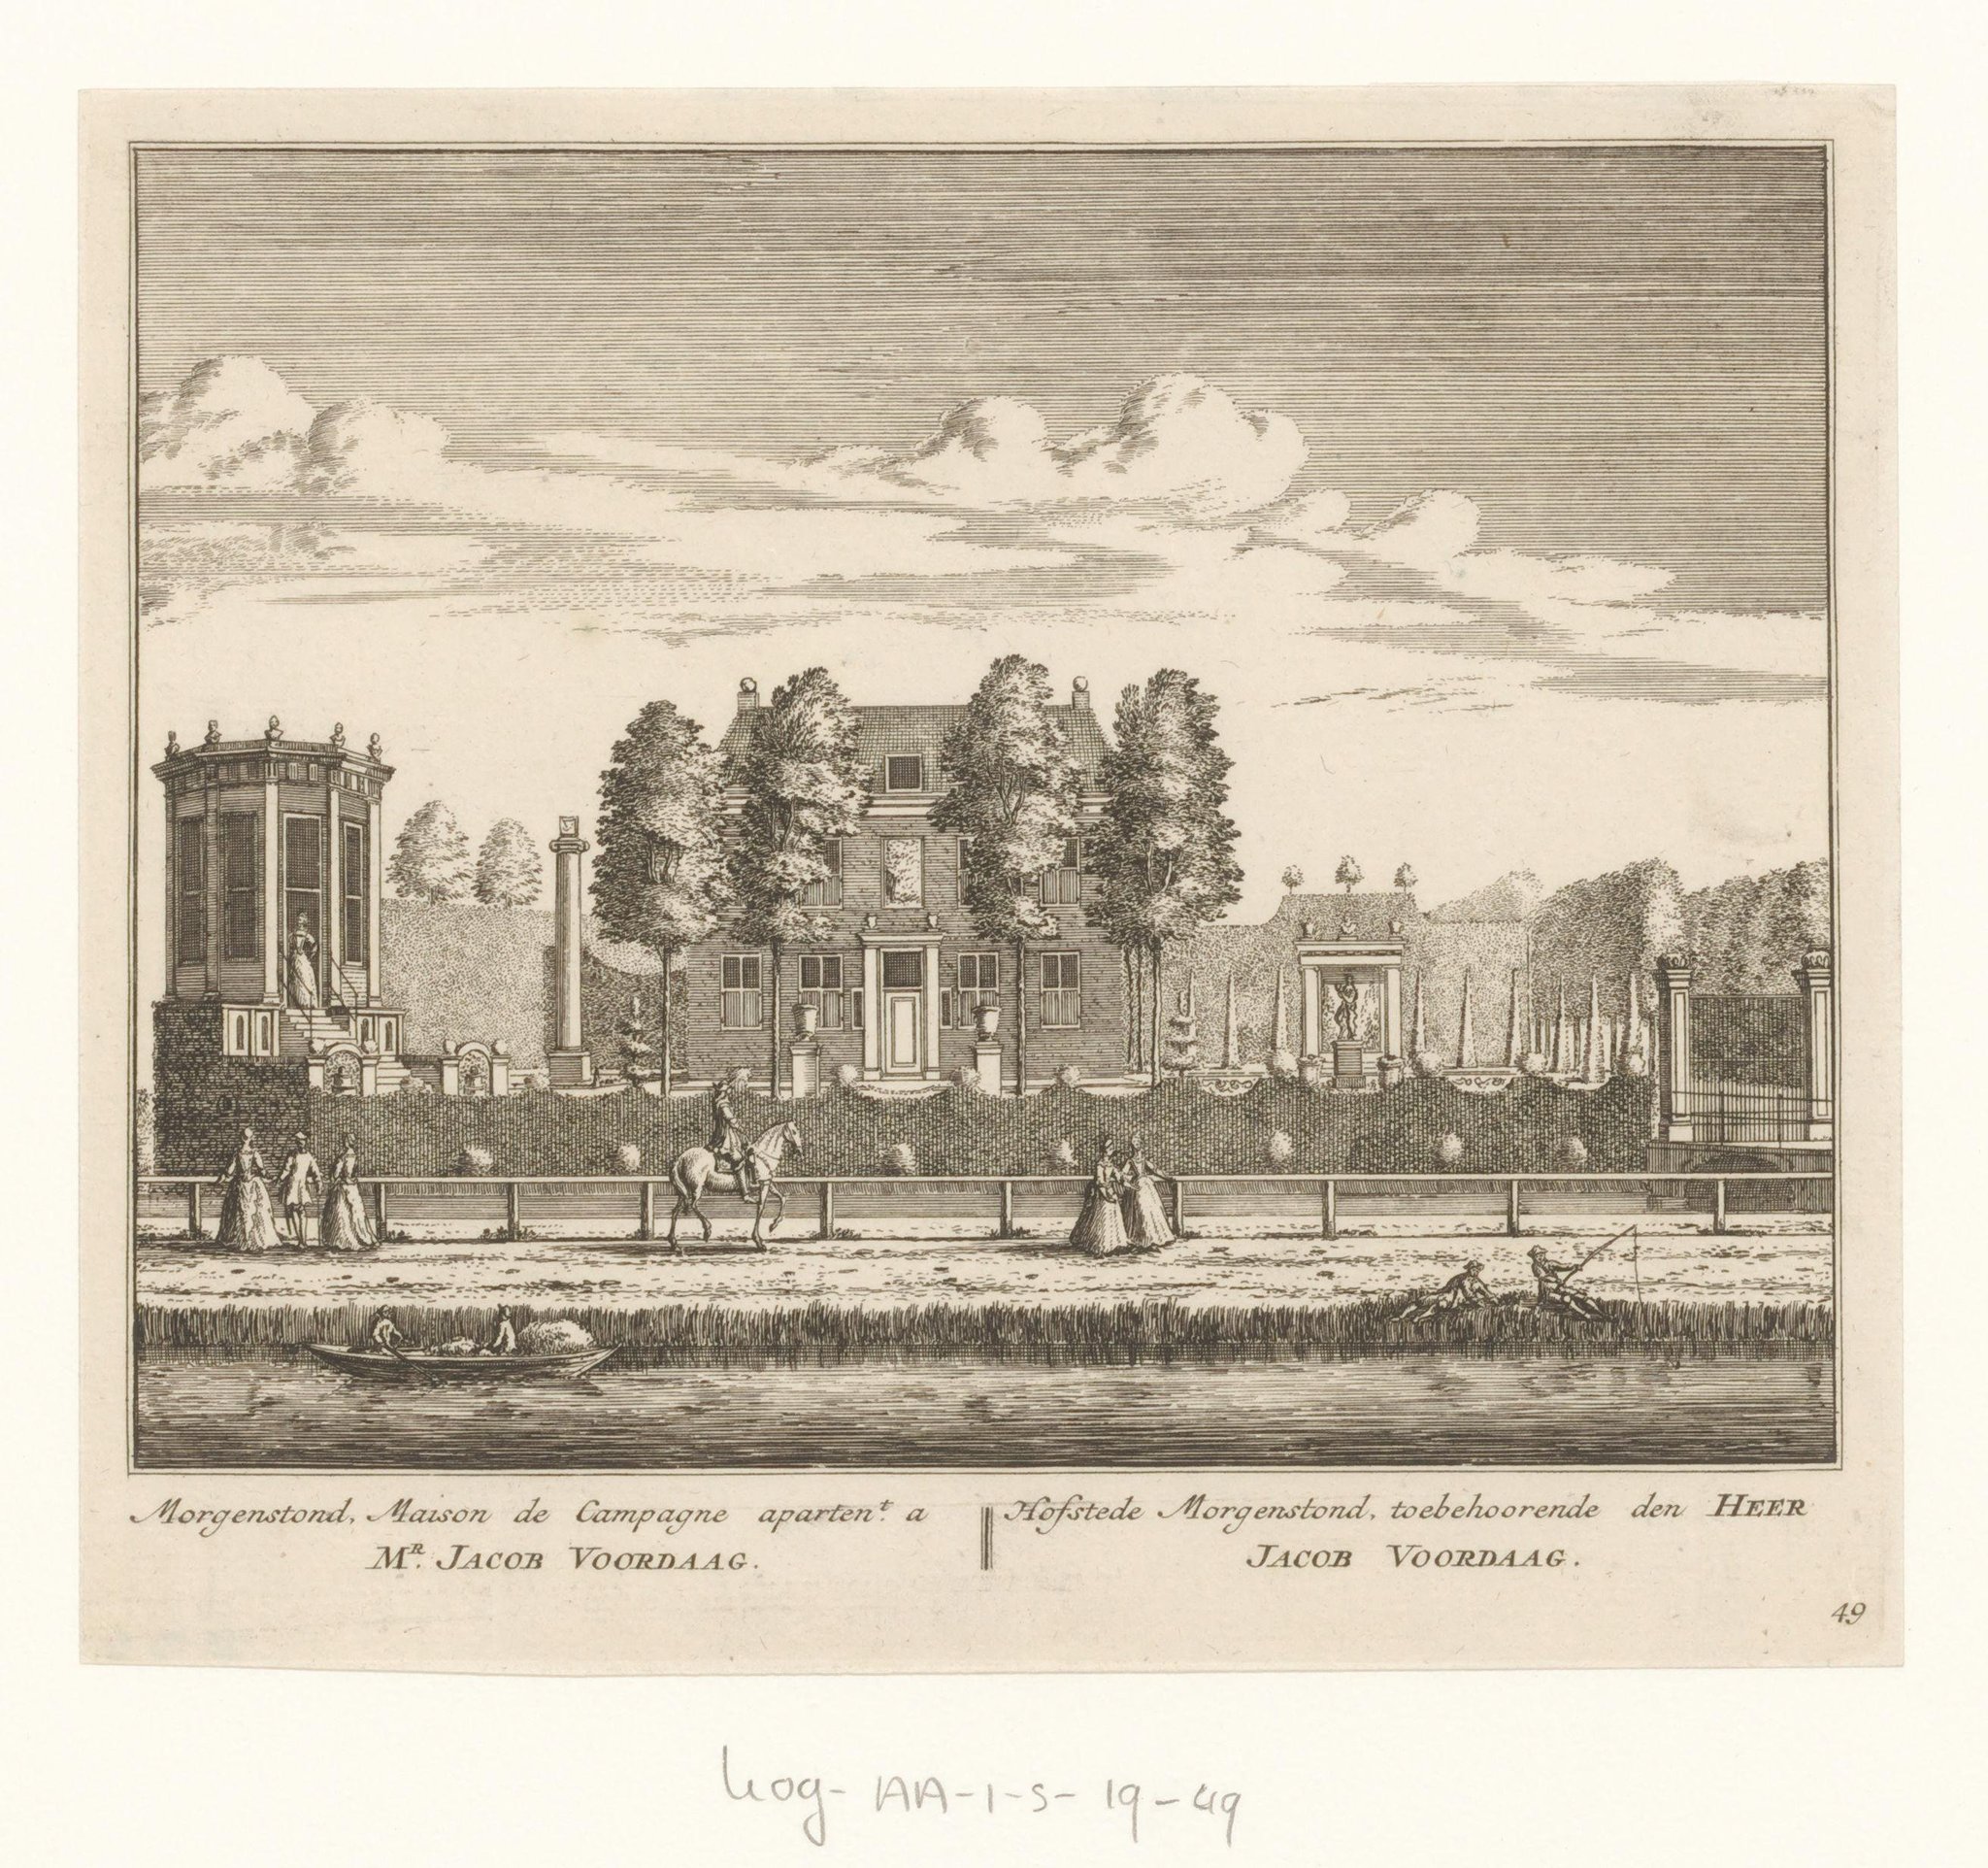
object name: print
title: Hollands Arcadia, of de vermaarde rivier den Amstel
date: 1730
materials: paper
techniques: etching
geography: amsterdam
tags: city-view in general; 'veduta', river, rural housing, e.g. country-house, villa, cottage, gate, entrance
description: Prent waarschijnlijk uit: Tijsens, Gijsbert. Hollands Arcadia, of de vermaarde rivier den Amstel (...) naar 't léven getekend en in 't ligt gebragt door Abraham Rademaker (...). Amsterdam: Leonardus Schenk, 1730.